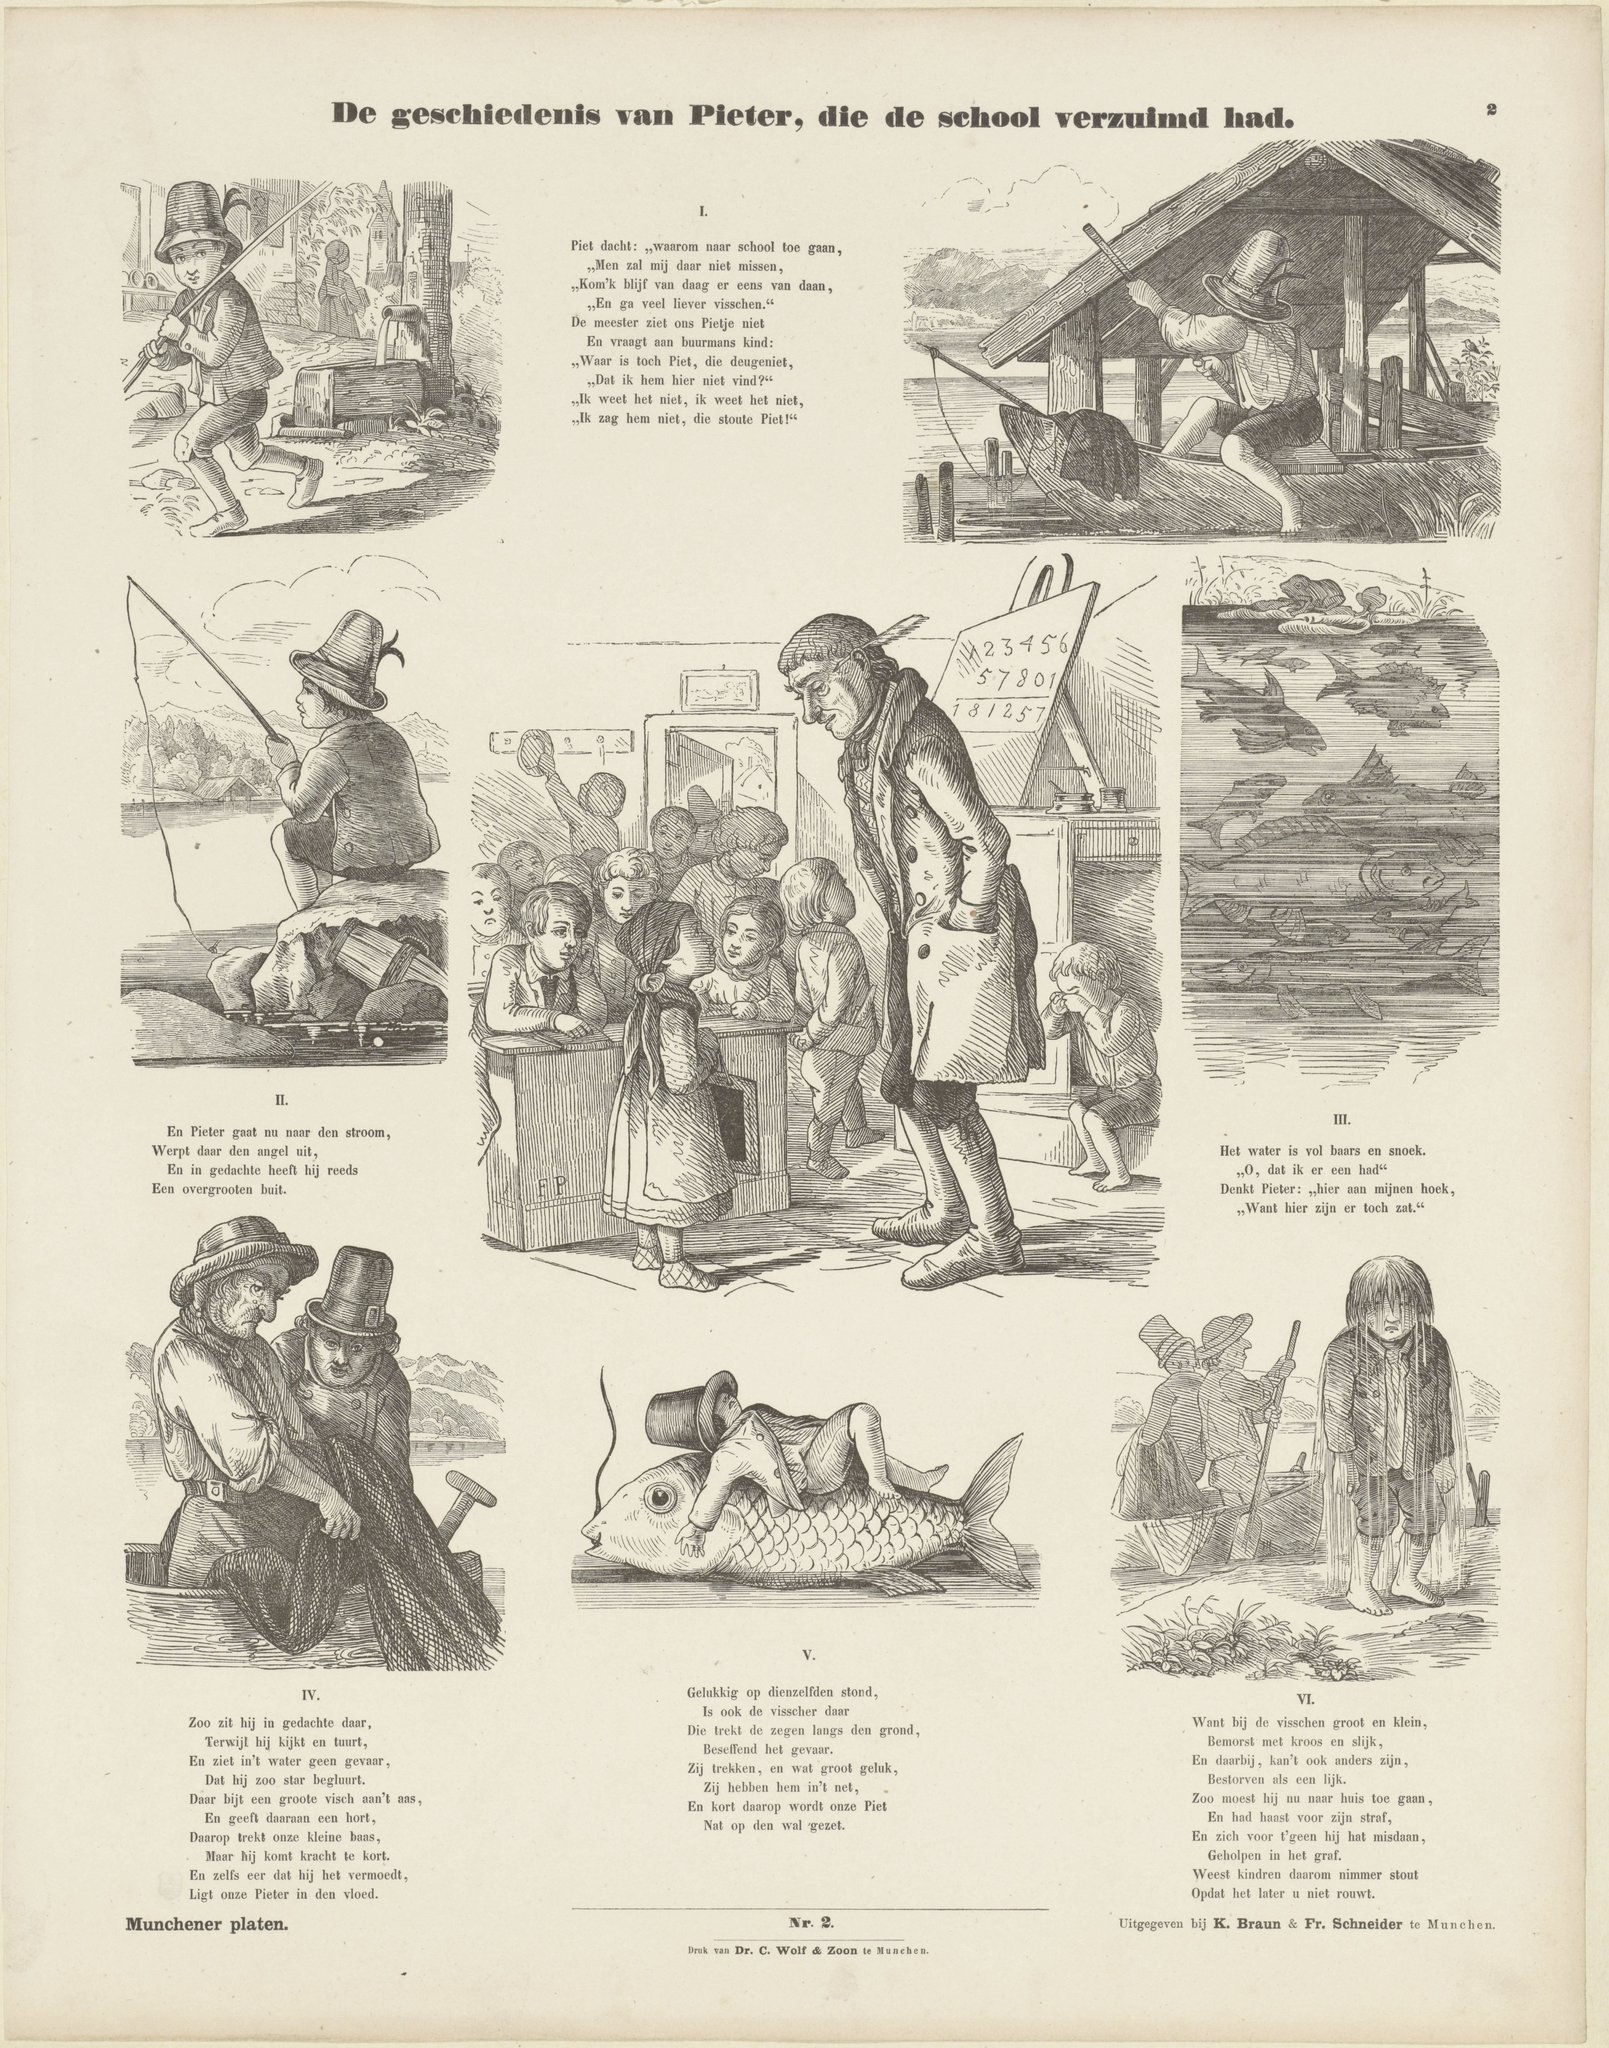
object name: print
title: De geschiedenis van Pieter, die de school verzuimd had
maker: franz graf von pocci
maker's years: 1807-1876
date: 1843-1920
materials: paper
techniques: letterpress printing, engraving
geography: munich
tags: commercial fishery (+ variant), fishes, teacher and pupil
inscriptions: collector's mark: Lugt 2760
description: Blad met 8 voorstellingen over Pieter die liever gaat vissen dan naar school gaat. Hij valt in het water en wordt door vissers gered. Tussen de afbeeldingen zes genummerde versjes. Genummerd midden onder: Nr. 2. Genummerd rechtsboven: 2.